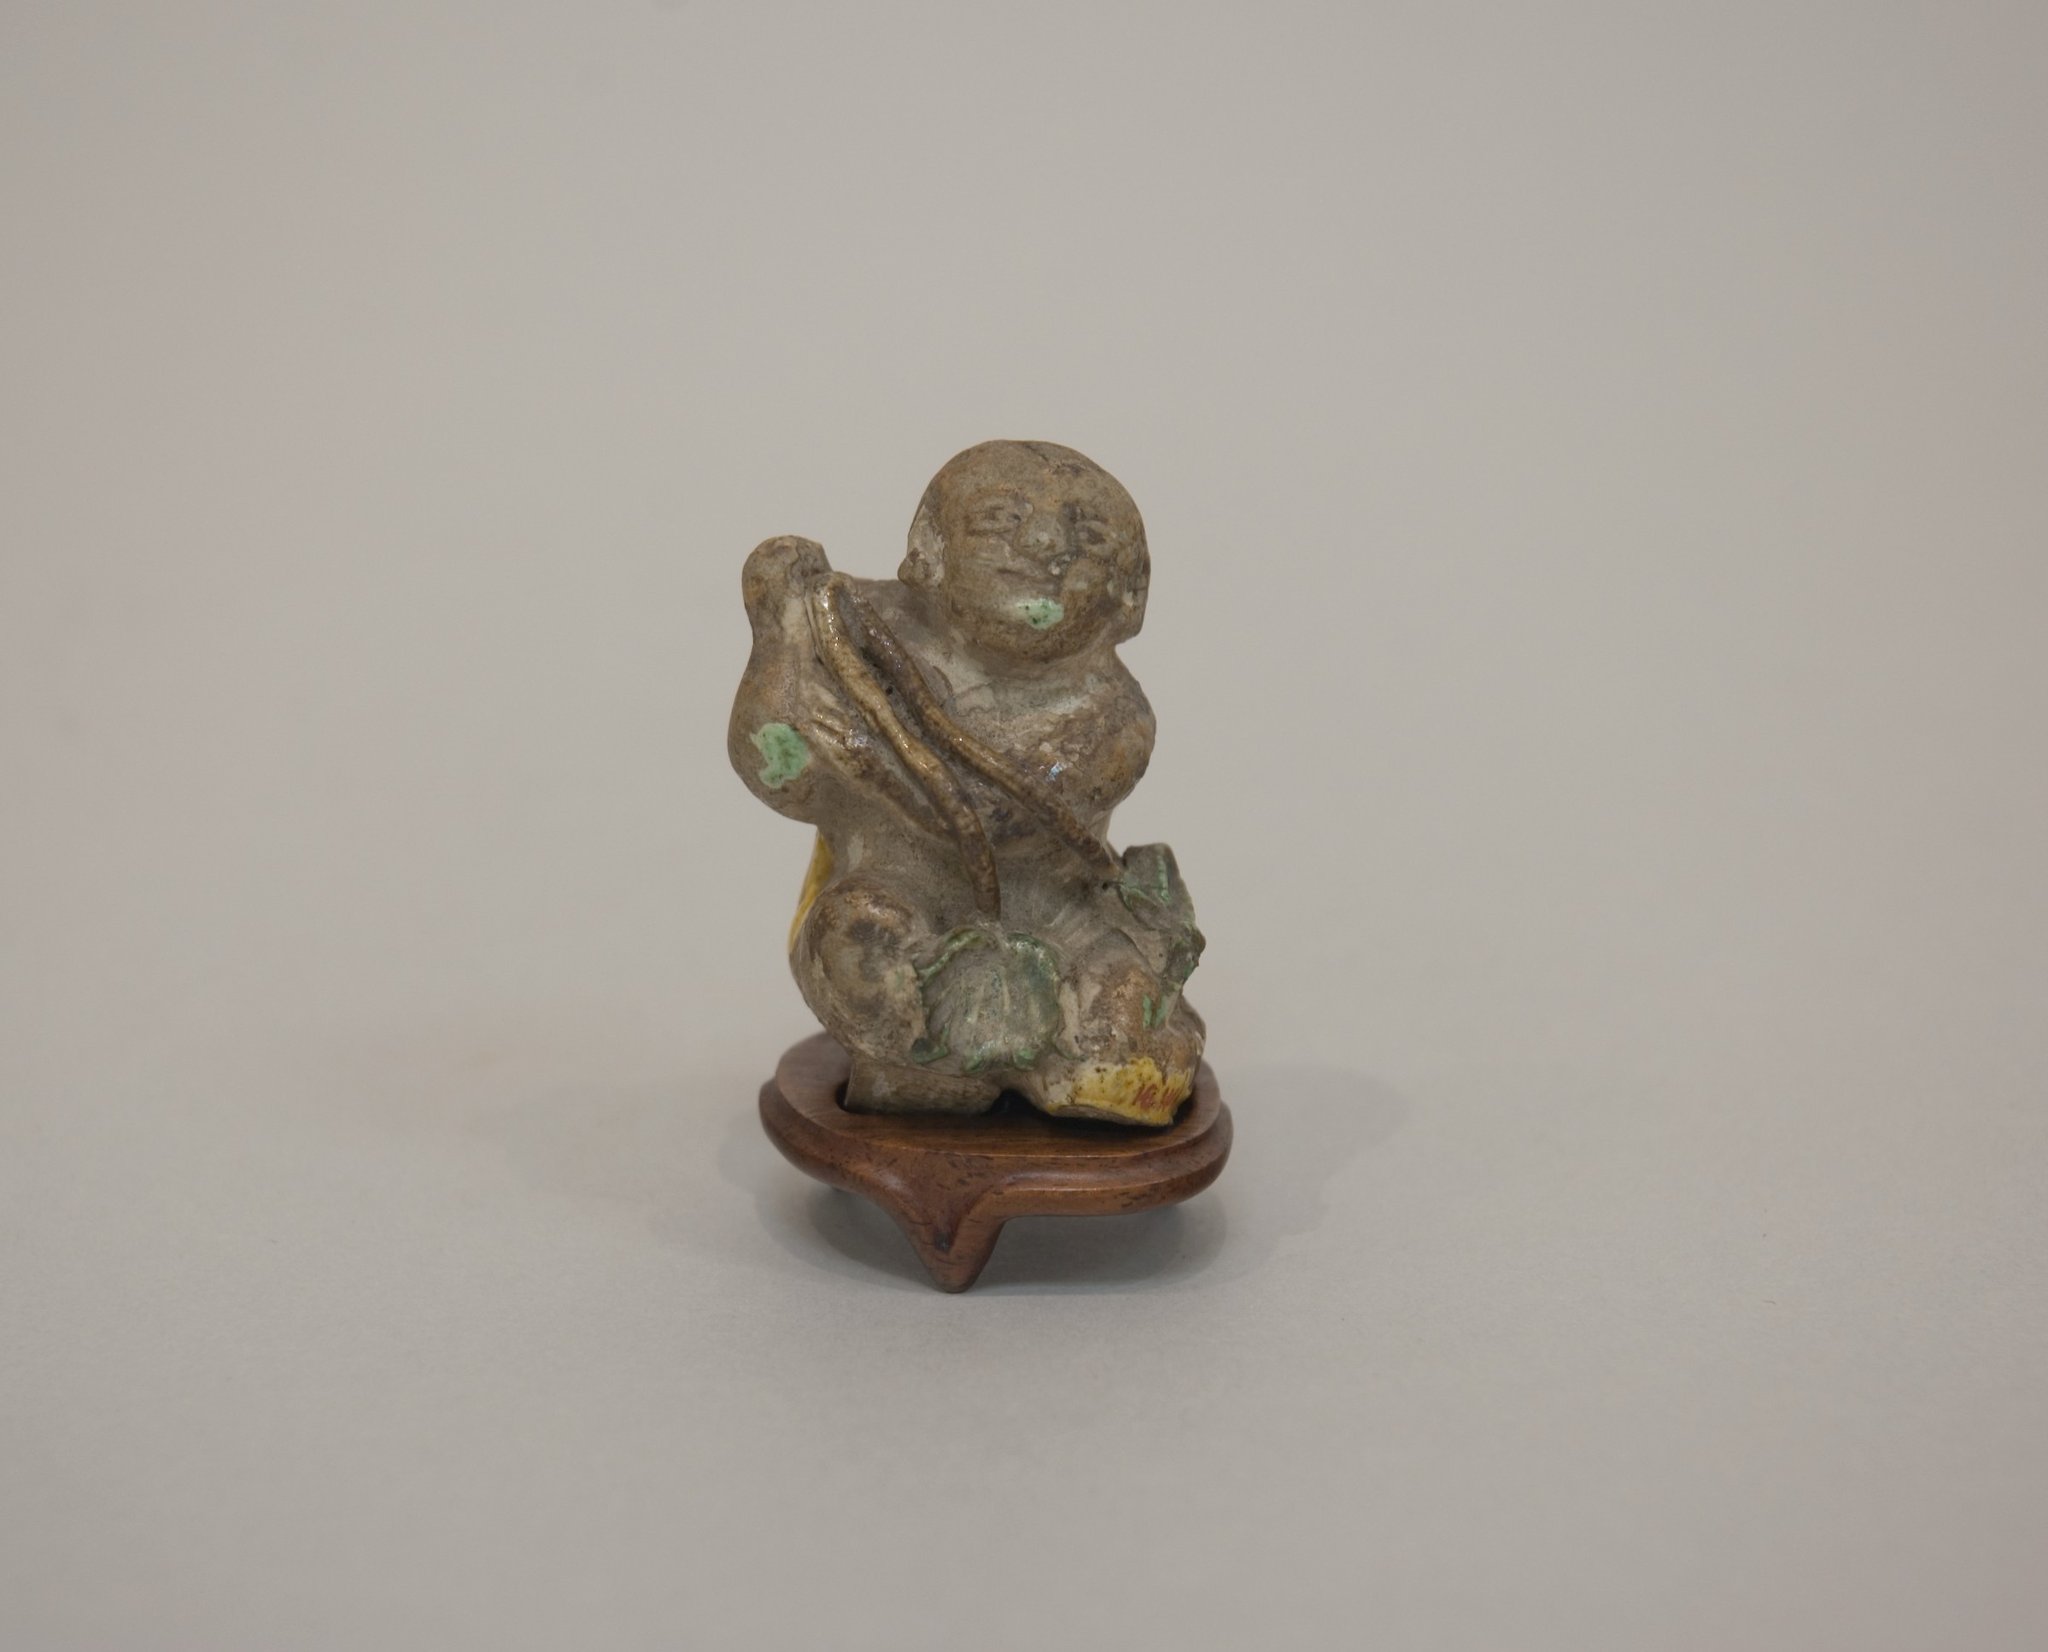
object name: figure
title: Doll of a boy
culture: chinese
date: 1001-1200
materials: stoneware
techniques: glazing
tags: boys